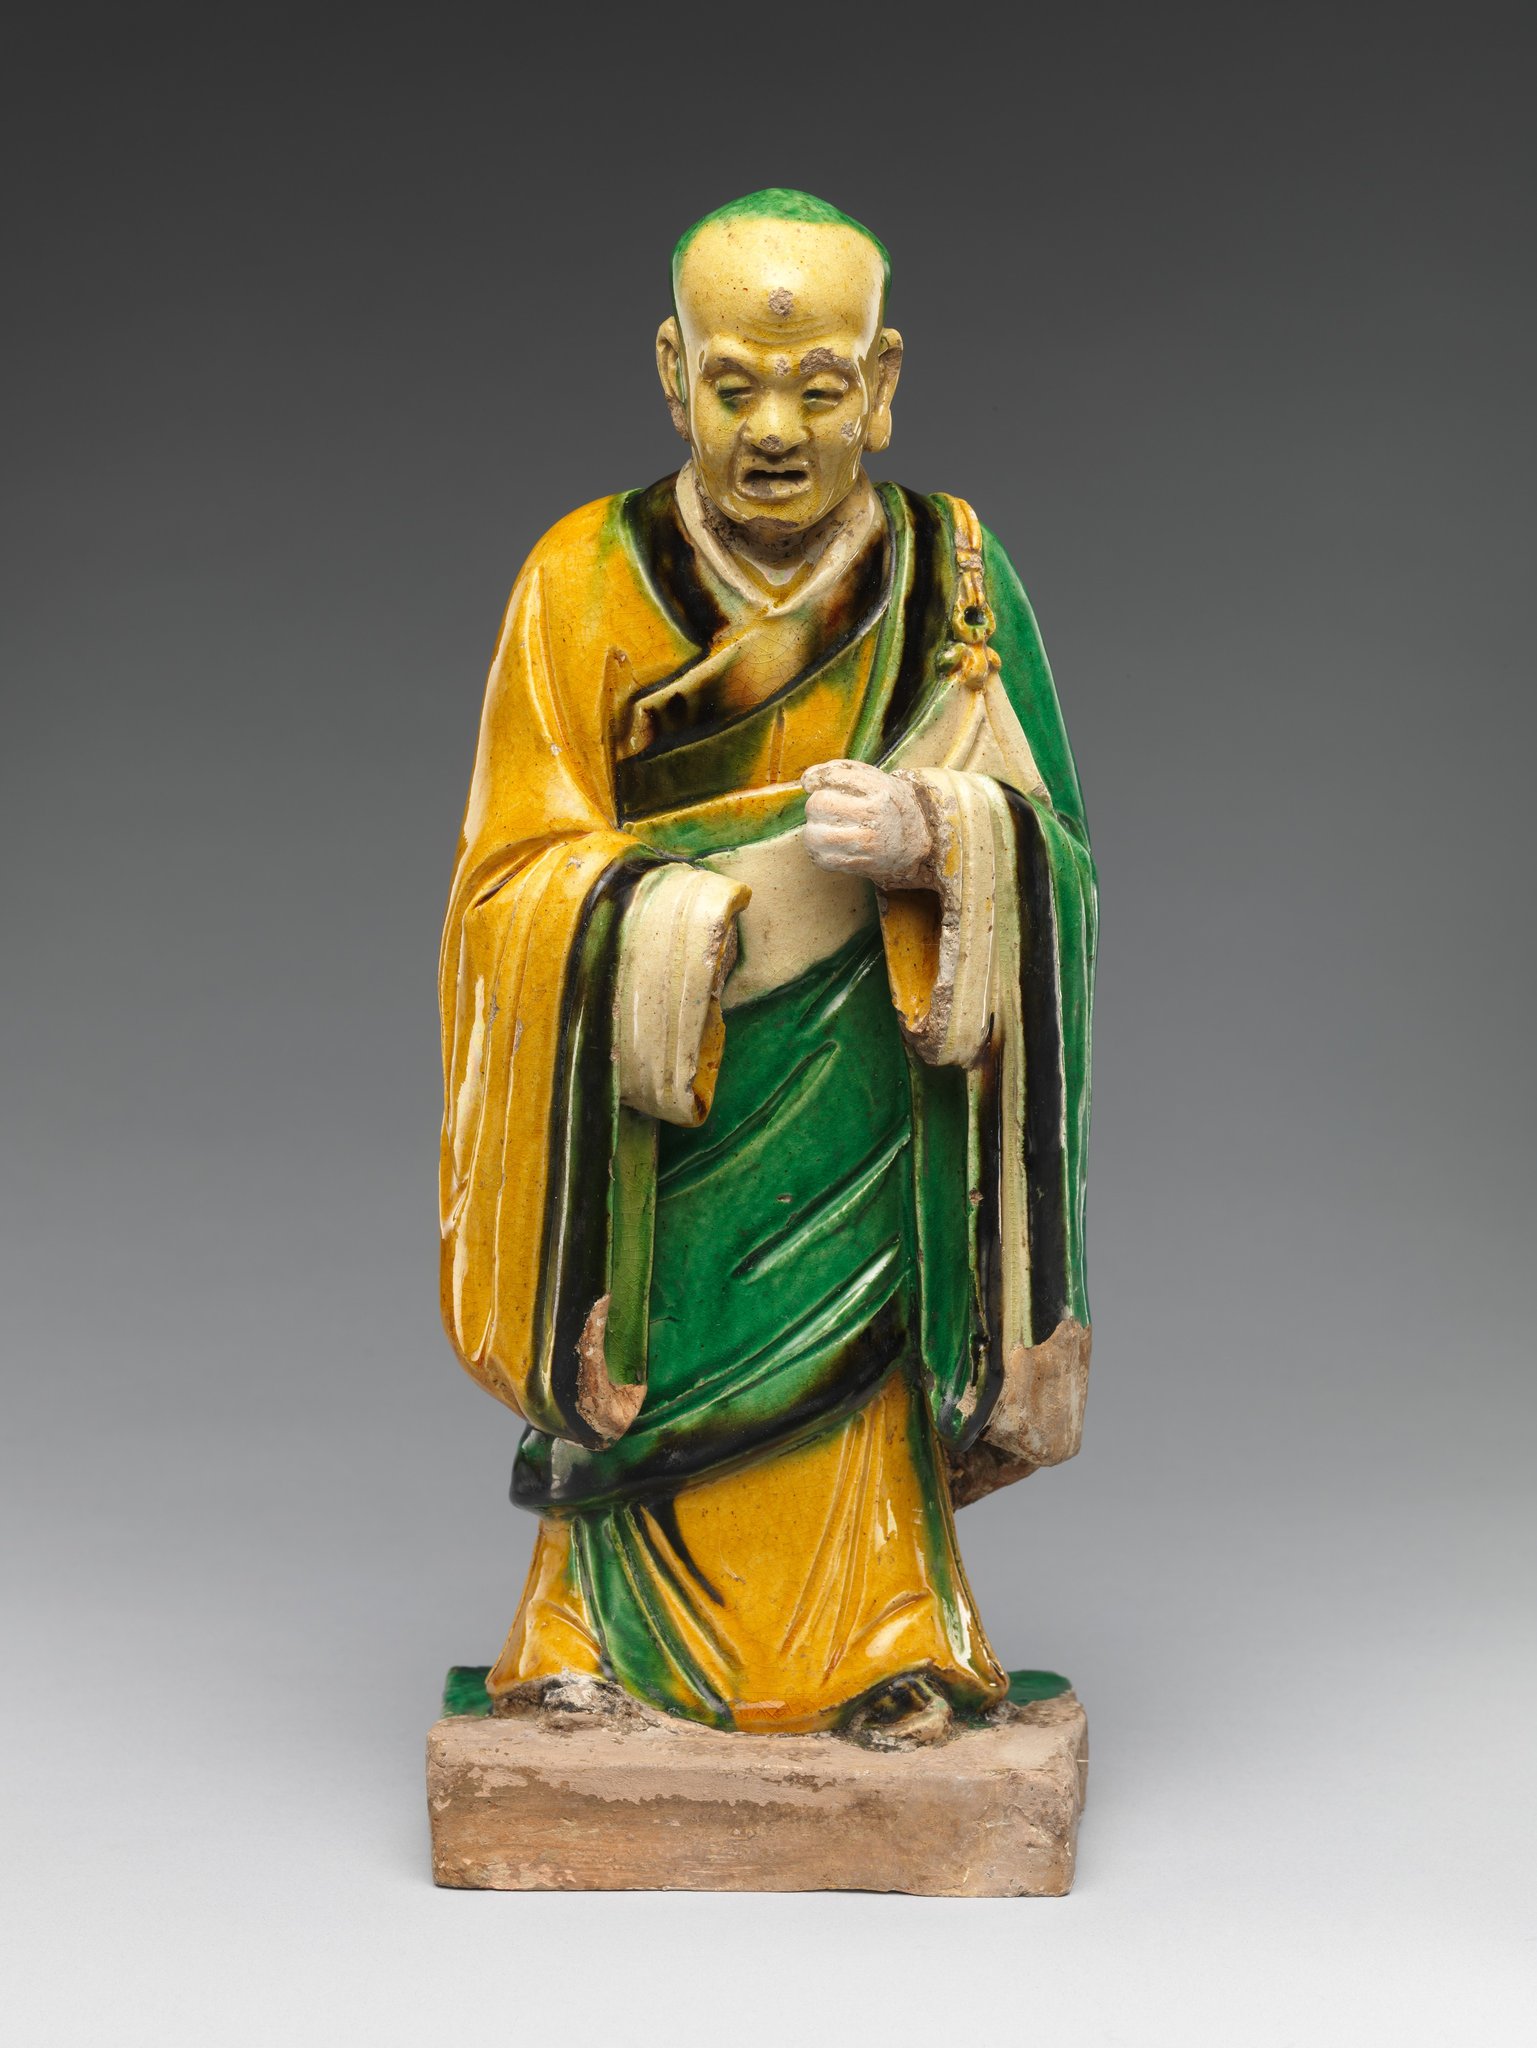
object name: figure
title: Par nirvana (death and transcendence of the Buddha) and attendant arhats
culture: chinese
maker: qiao bin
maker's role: artist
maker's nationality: chinese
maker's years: 1481-1507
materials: earthenware, glaze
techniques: polychrome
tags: men